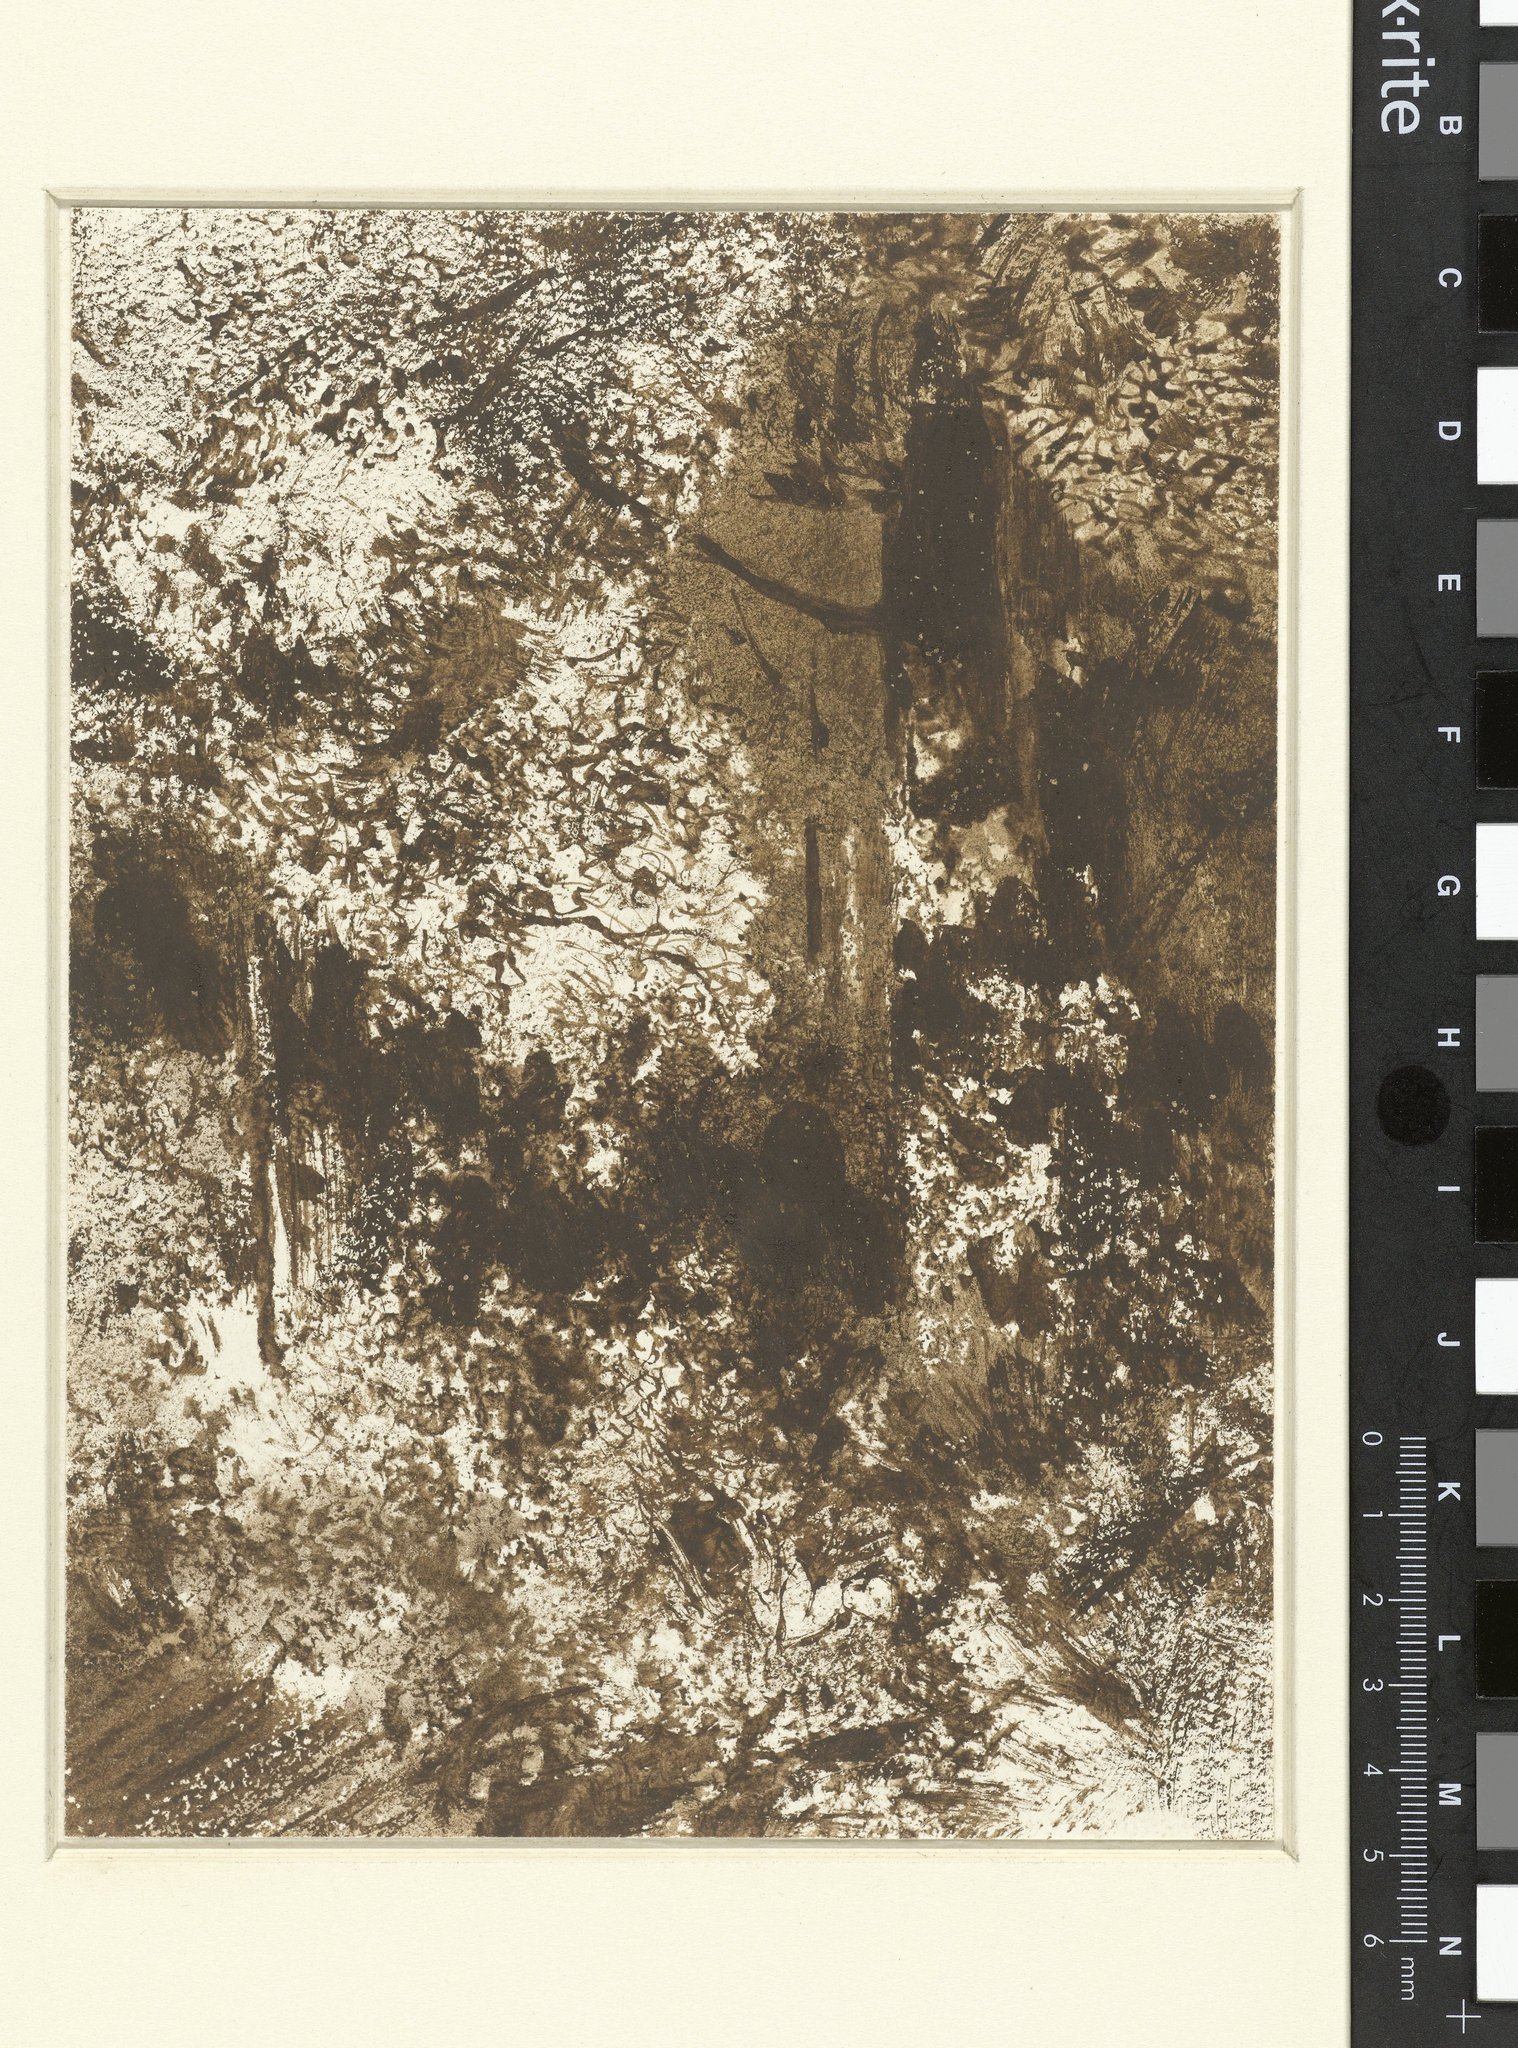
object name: drawing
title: Bosgezicht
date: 1830-1870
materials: paper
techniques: brush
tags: forest, wood